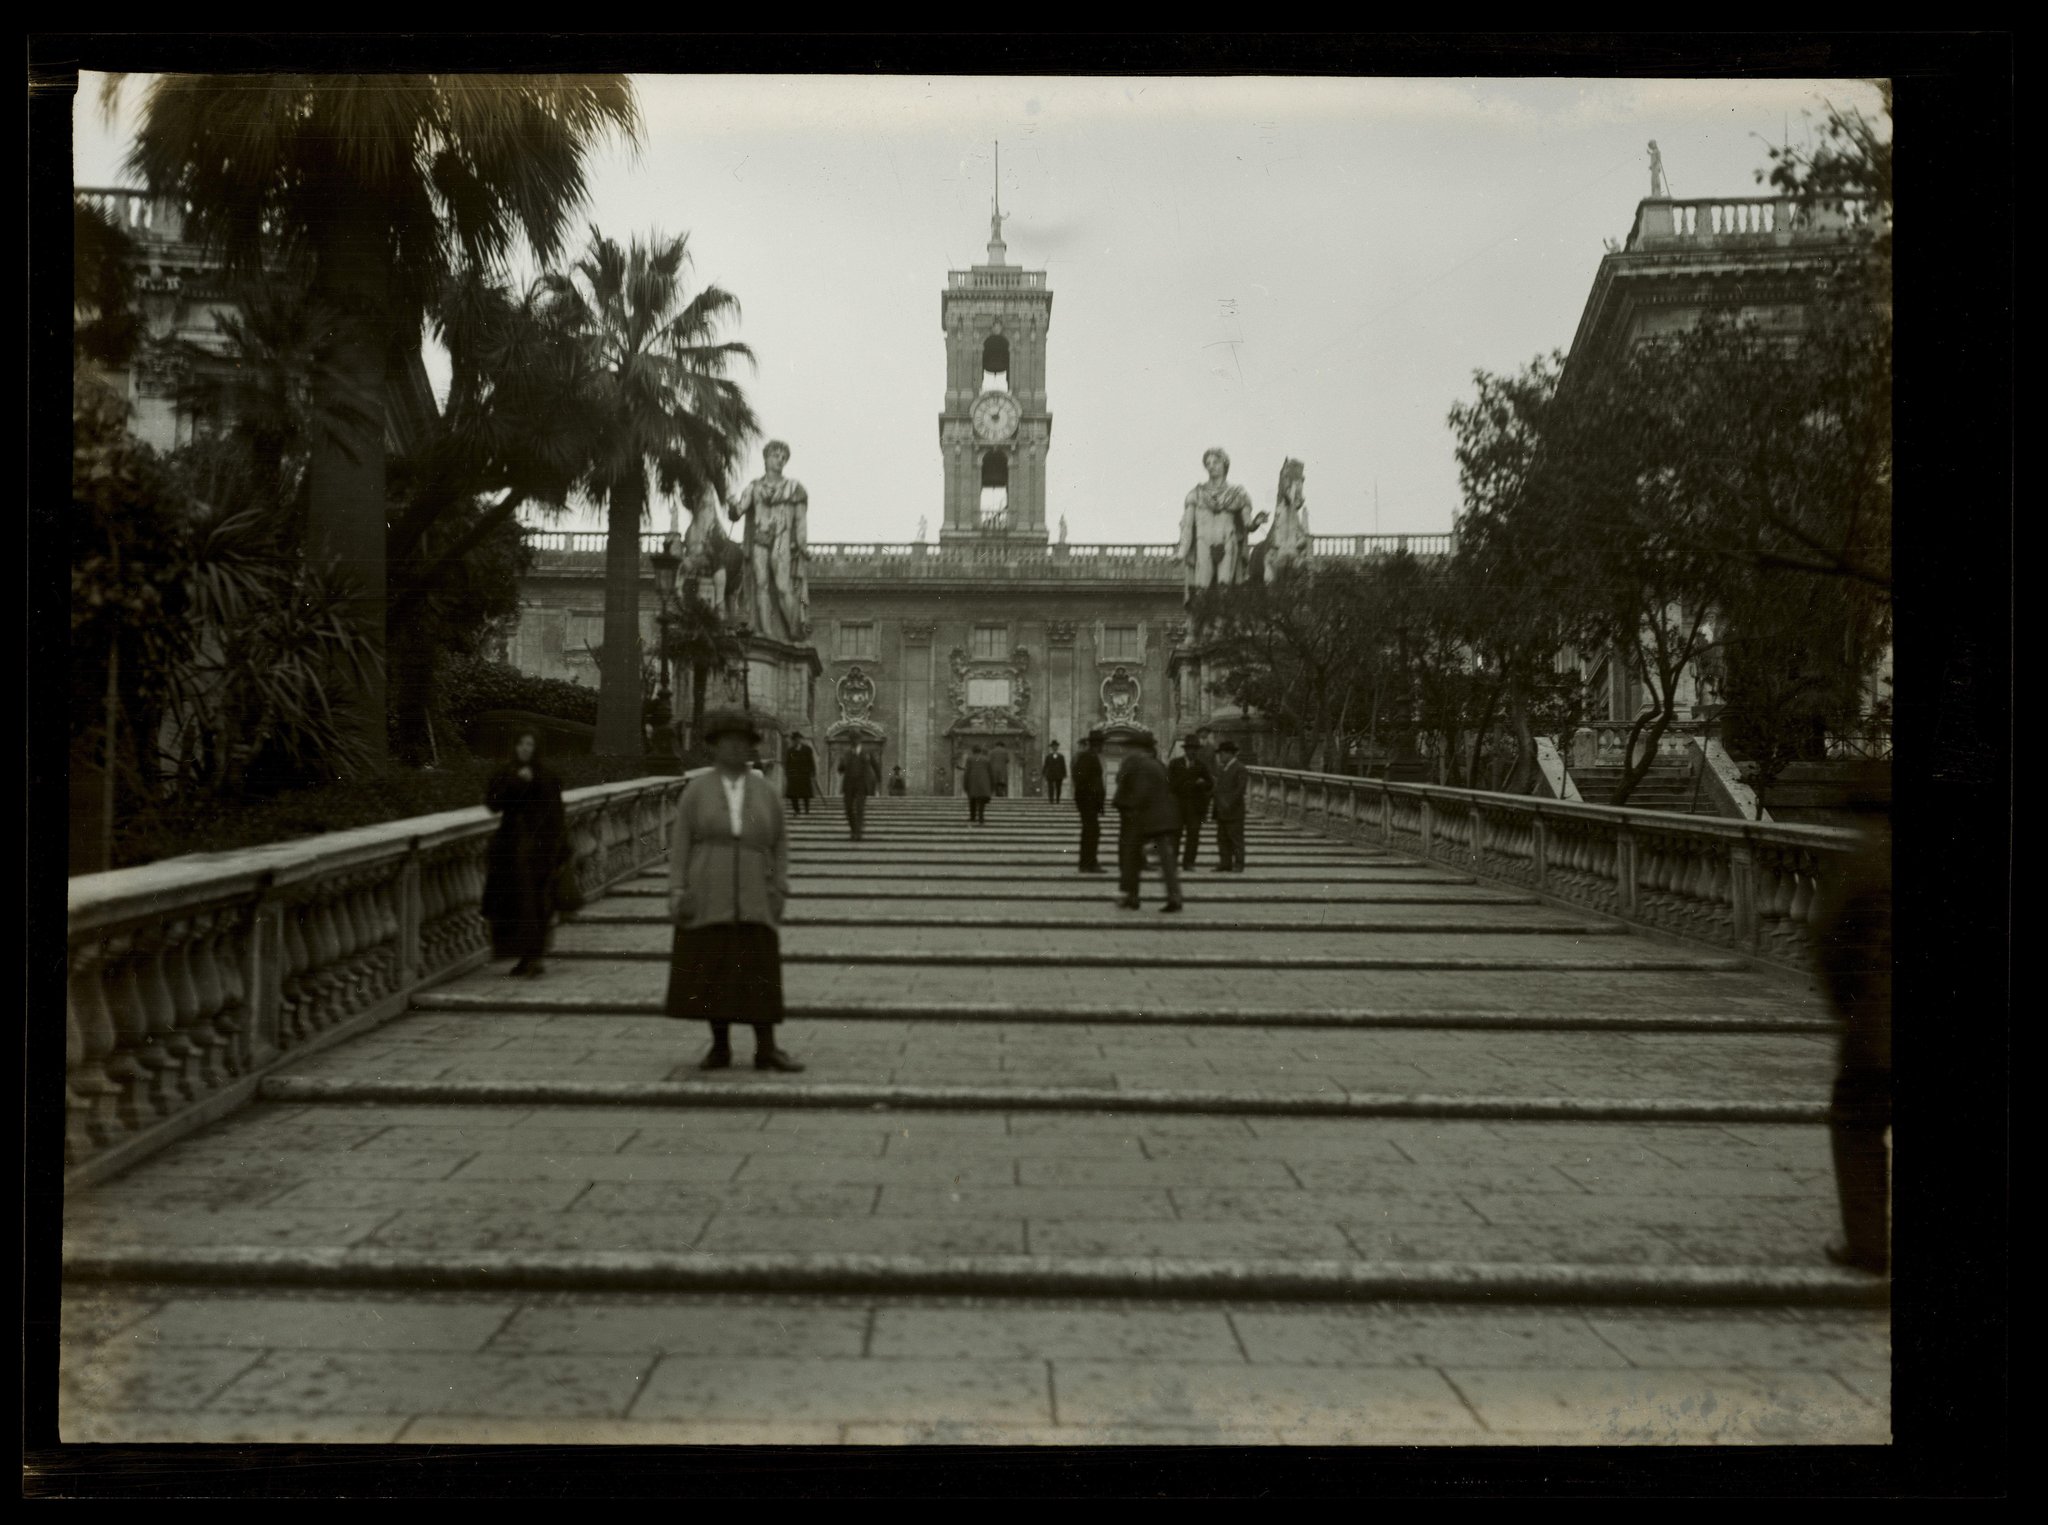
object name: photograph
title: Filmnegatief met opname van Rome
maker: Anonymous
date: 1907-1935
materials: film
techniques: gelatin silver negative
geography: rome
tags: rome